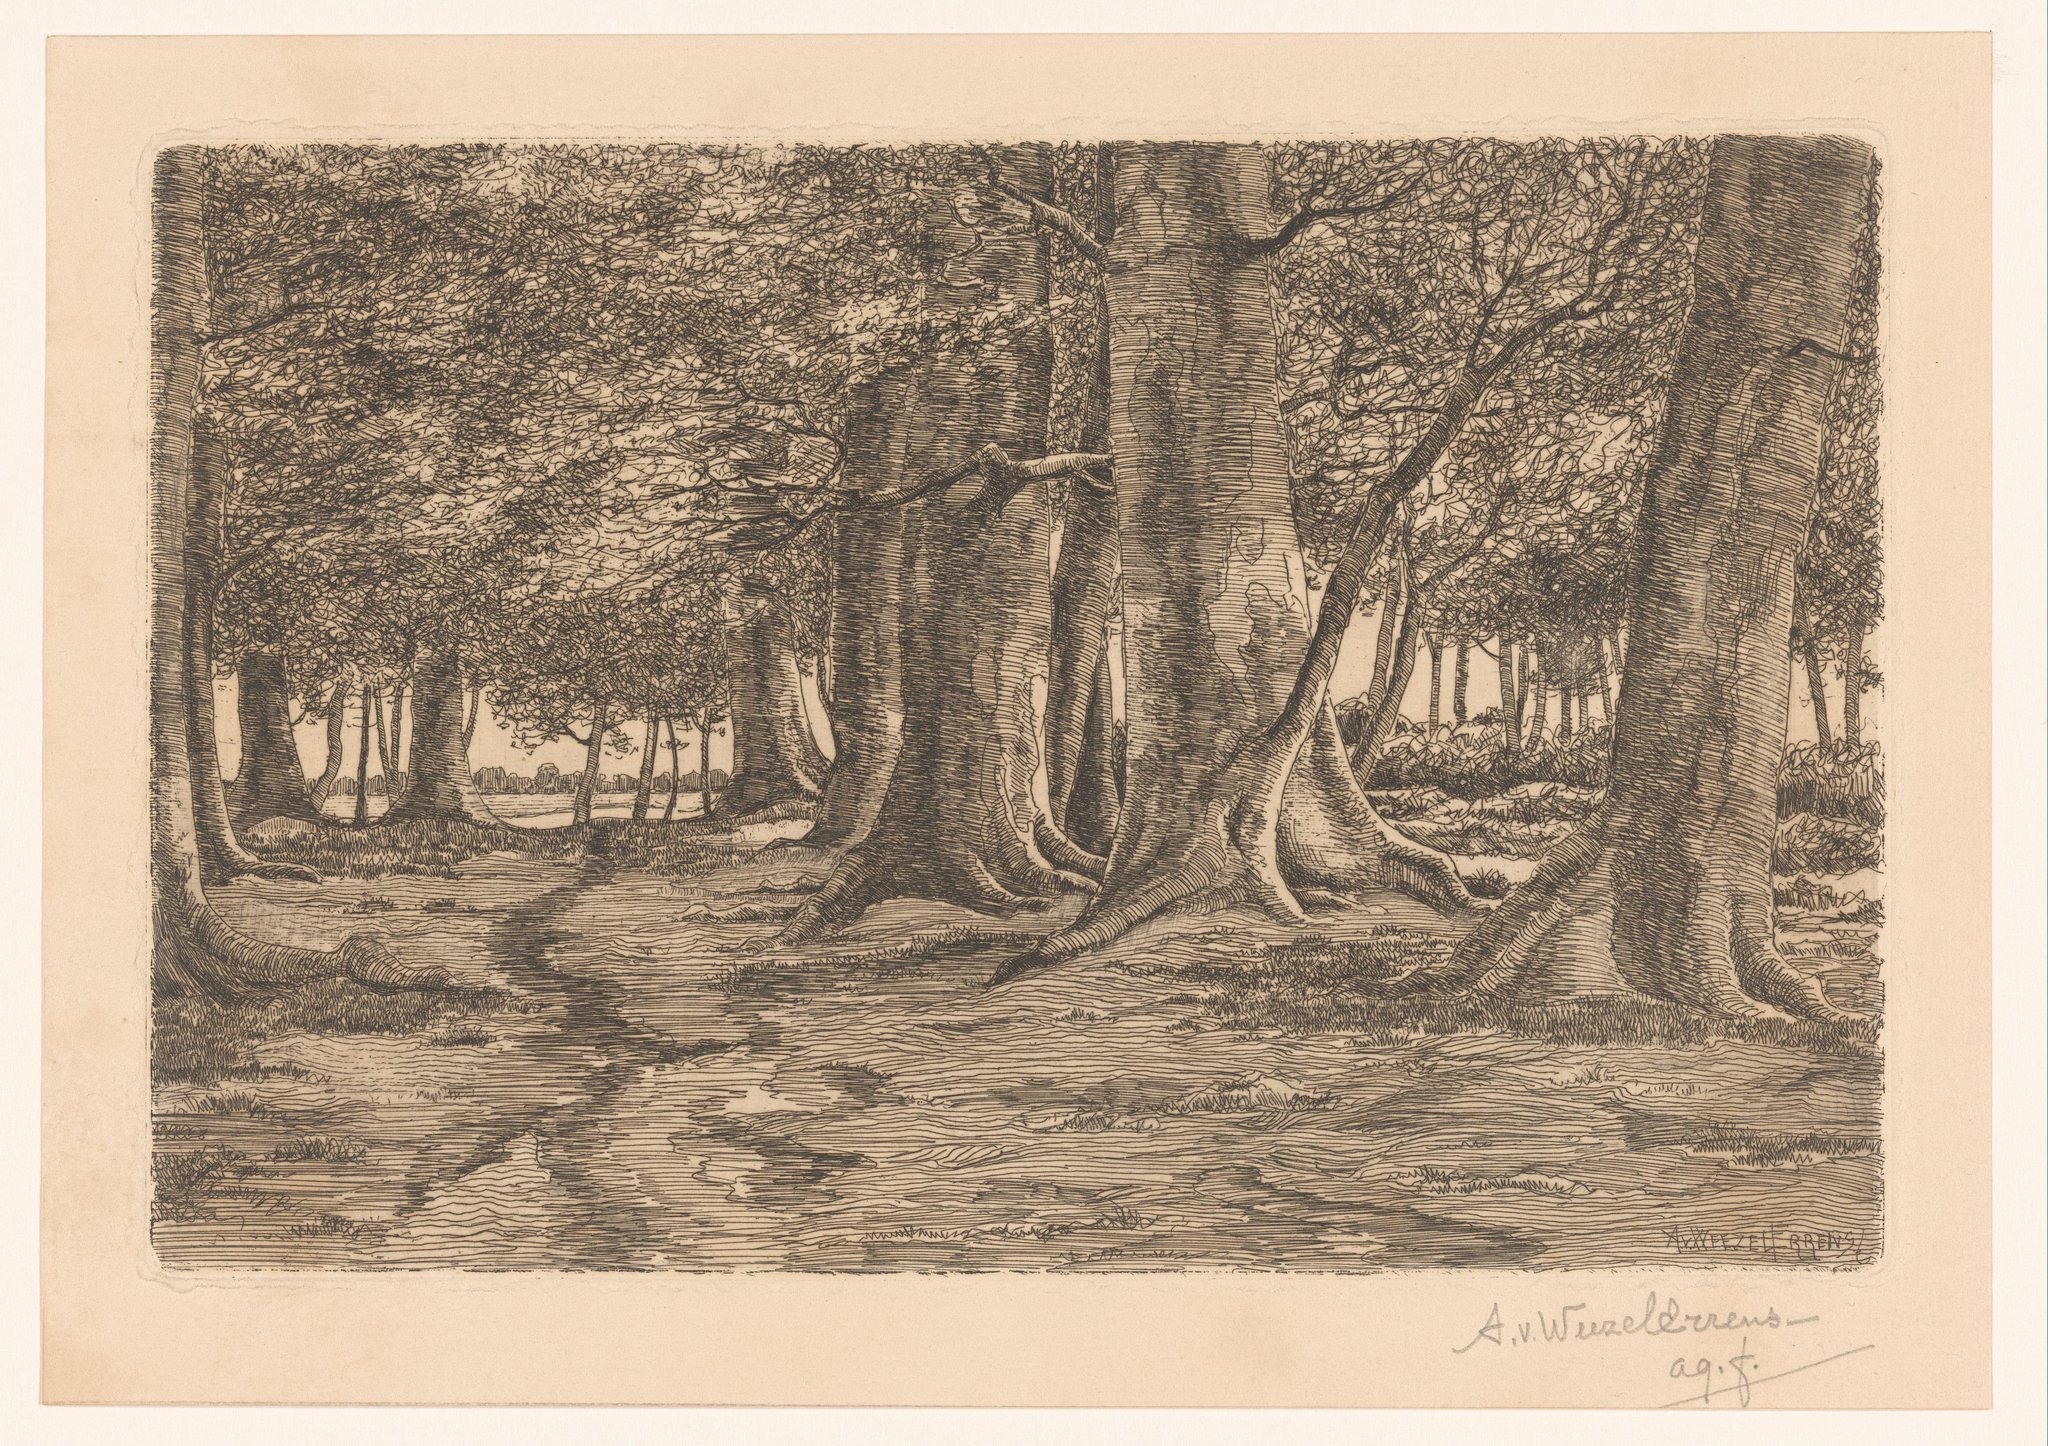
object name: print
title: Beuken bij het Uddelermeer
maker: adolphe p.h j. van weezel errens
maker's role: print maker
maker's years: 1866-1939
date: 1876-1911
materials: paper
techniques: etching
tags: trees, landscapes in the temperate zone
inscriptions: collector's mark: Lugt 2228